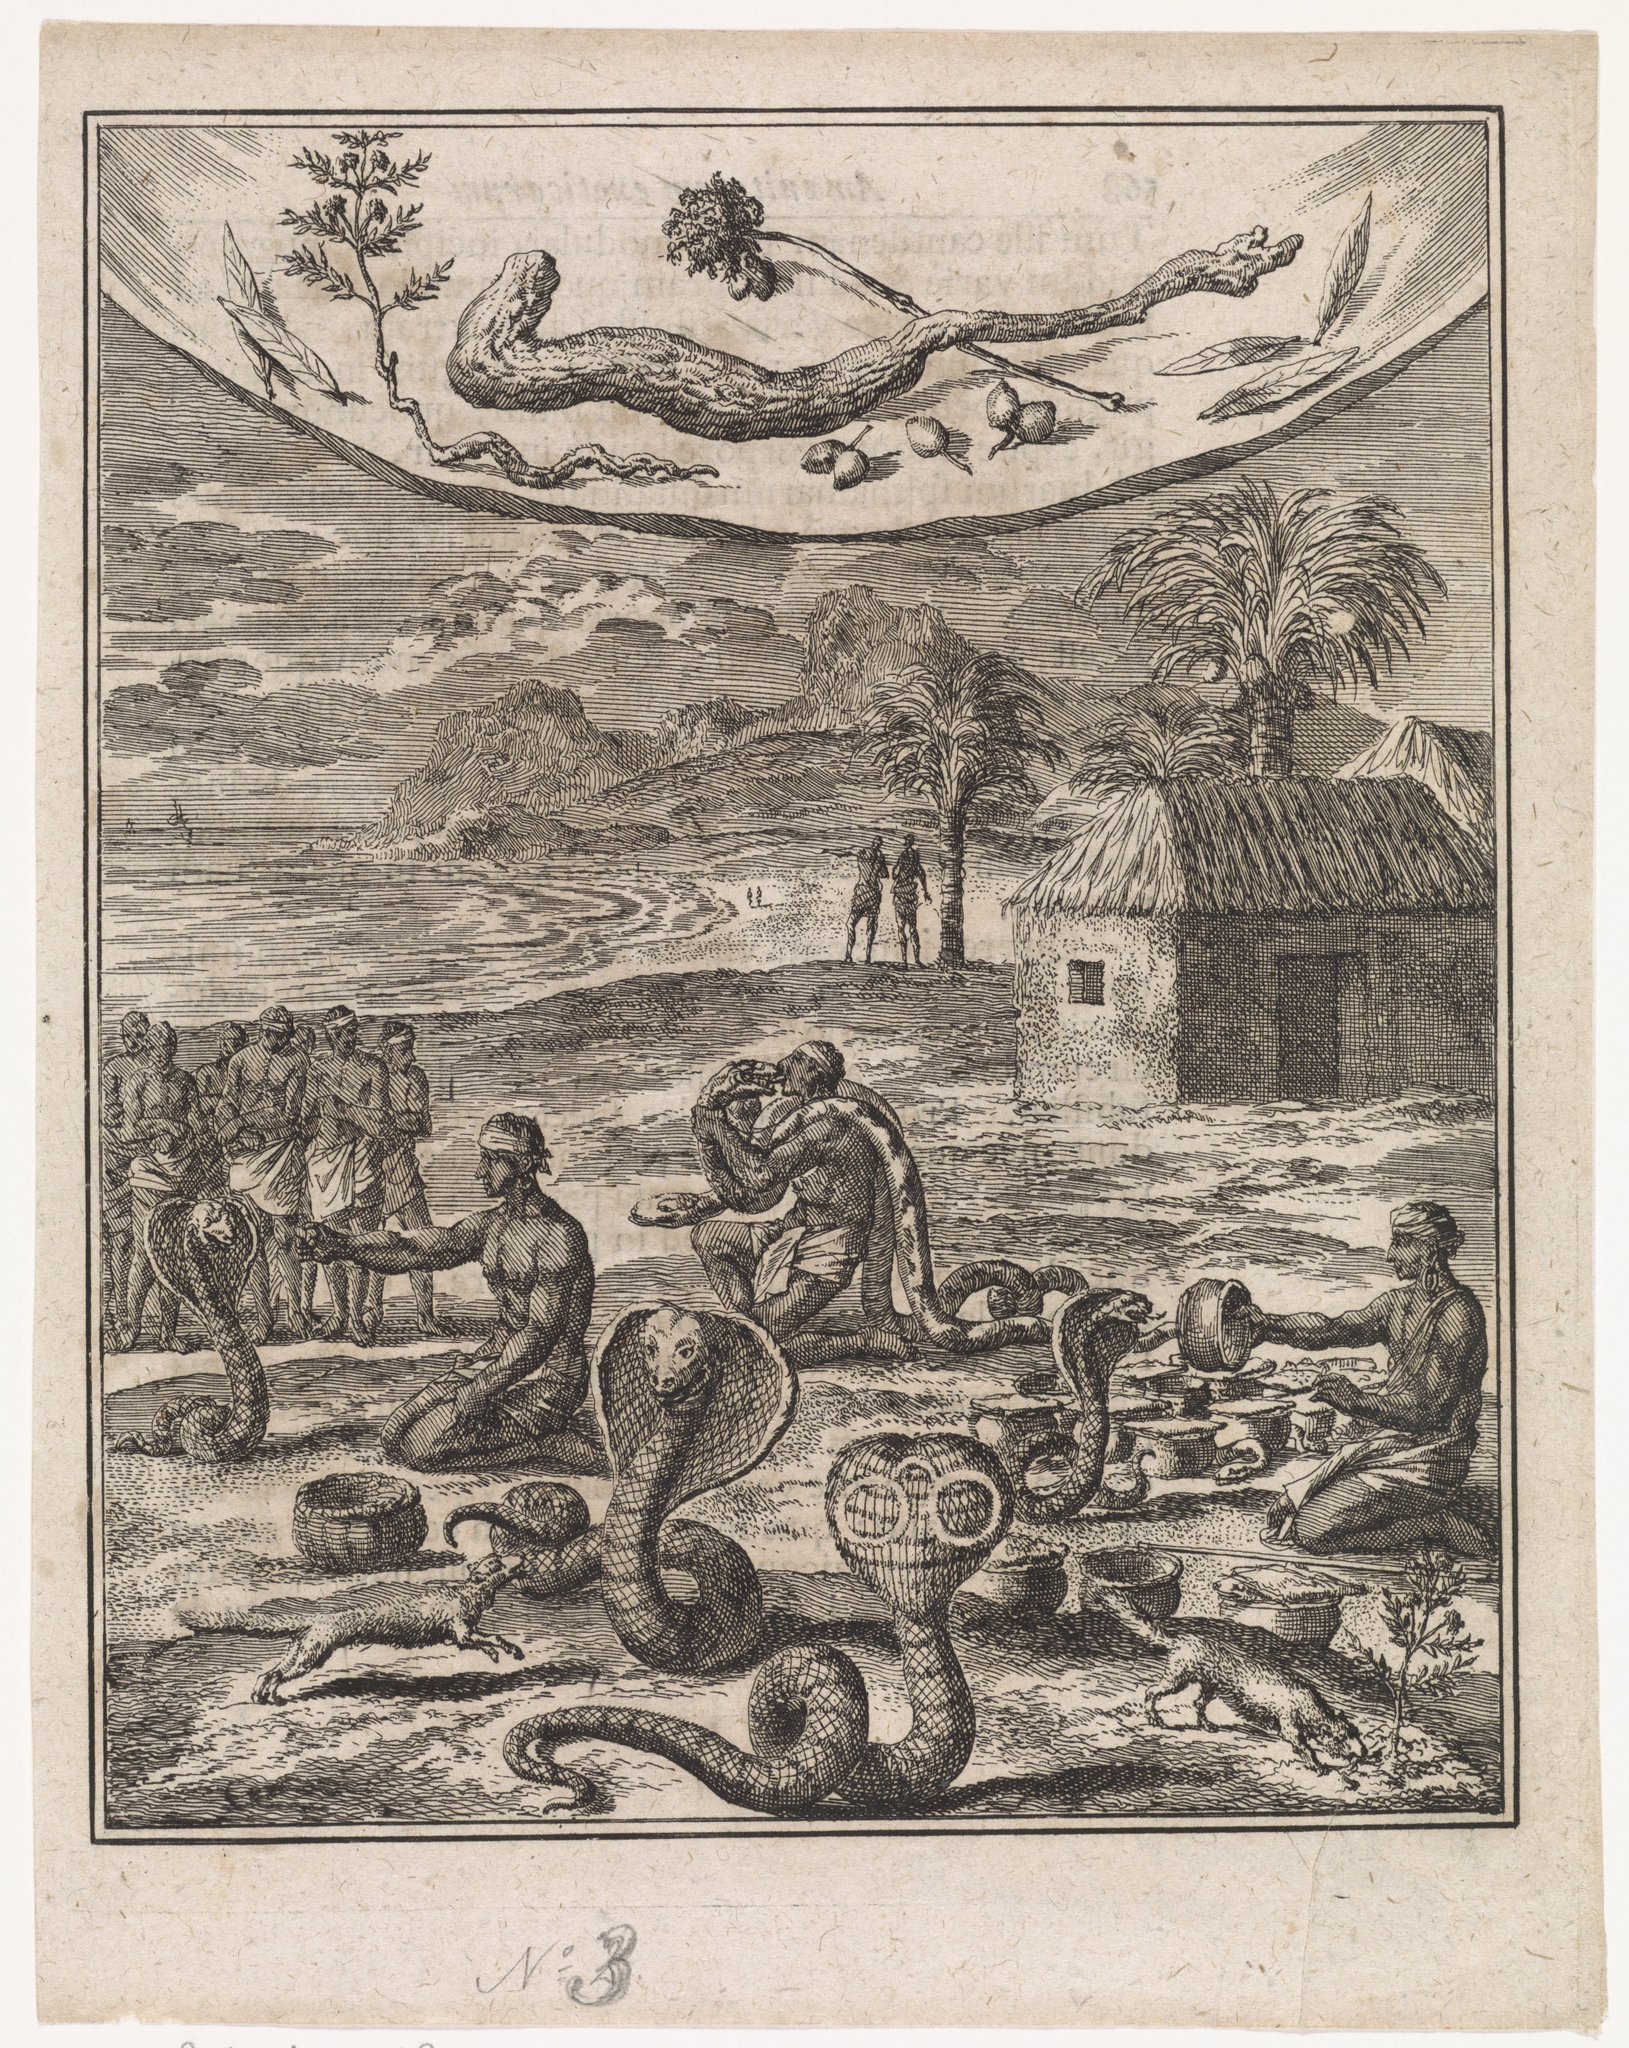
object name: book illustration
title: Slangenbezweerders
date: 1712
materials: paper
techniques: etching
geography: amsterdam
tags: snakes (+ animal rotating, twisting)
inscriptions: collector's mark: Lugt 2228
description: Boekillustratie voor: Kaempfer, Engelbert. Amoenitatum Exoticarum politico-physico-medicarum Fasciculi V (...). Lemgo: H.W. Meyer, 1712.